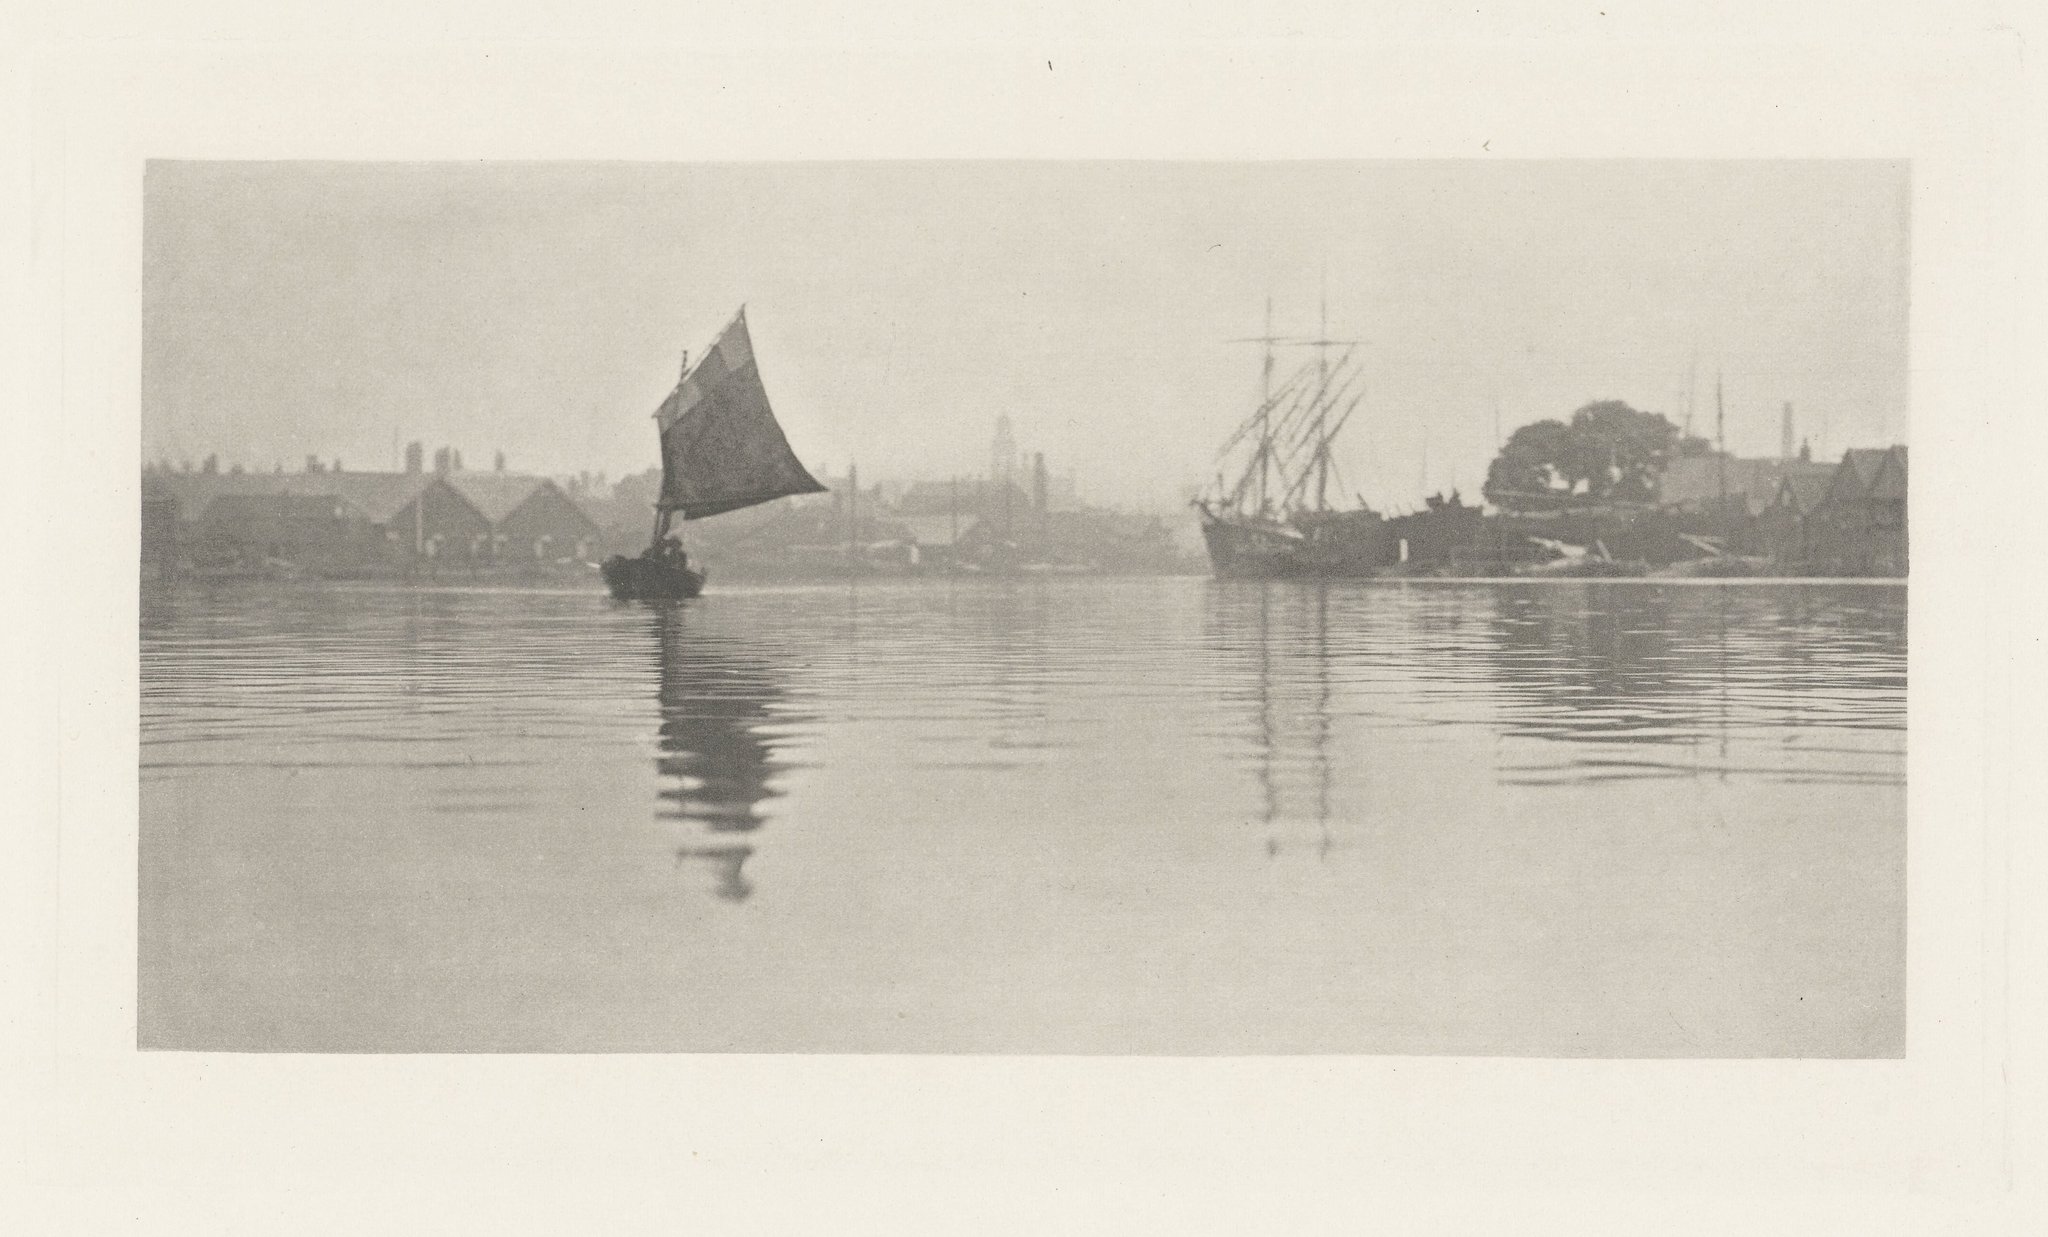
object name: photomechanical print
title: On the Flood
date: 1887-1890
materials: paper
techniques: photoaquatint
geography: london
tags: ships (in general) - cc - more than one ship, prospect of city, town panorama, silhouette of city, great britain